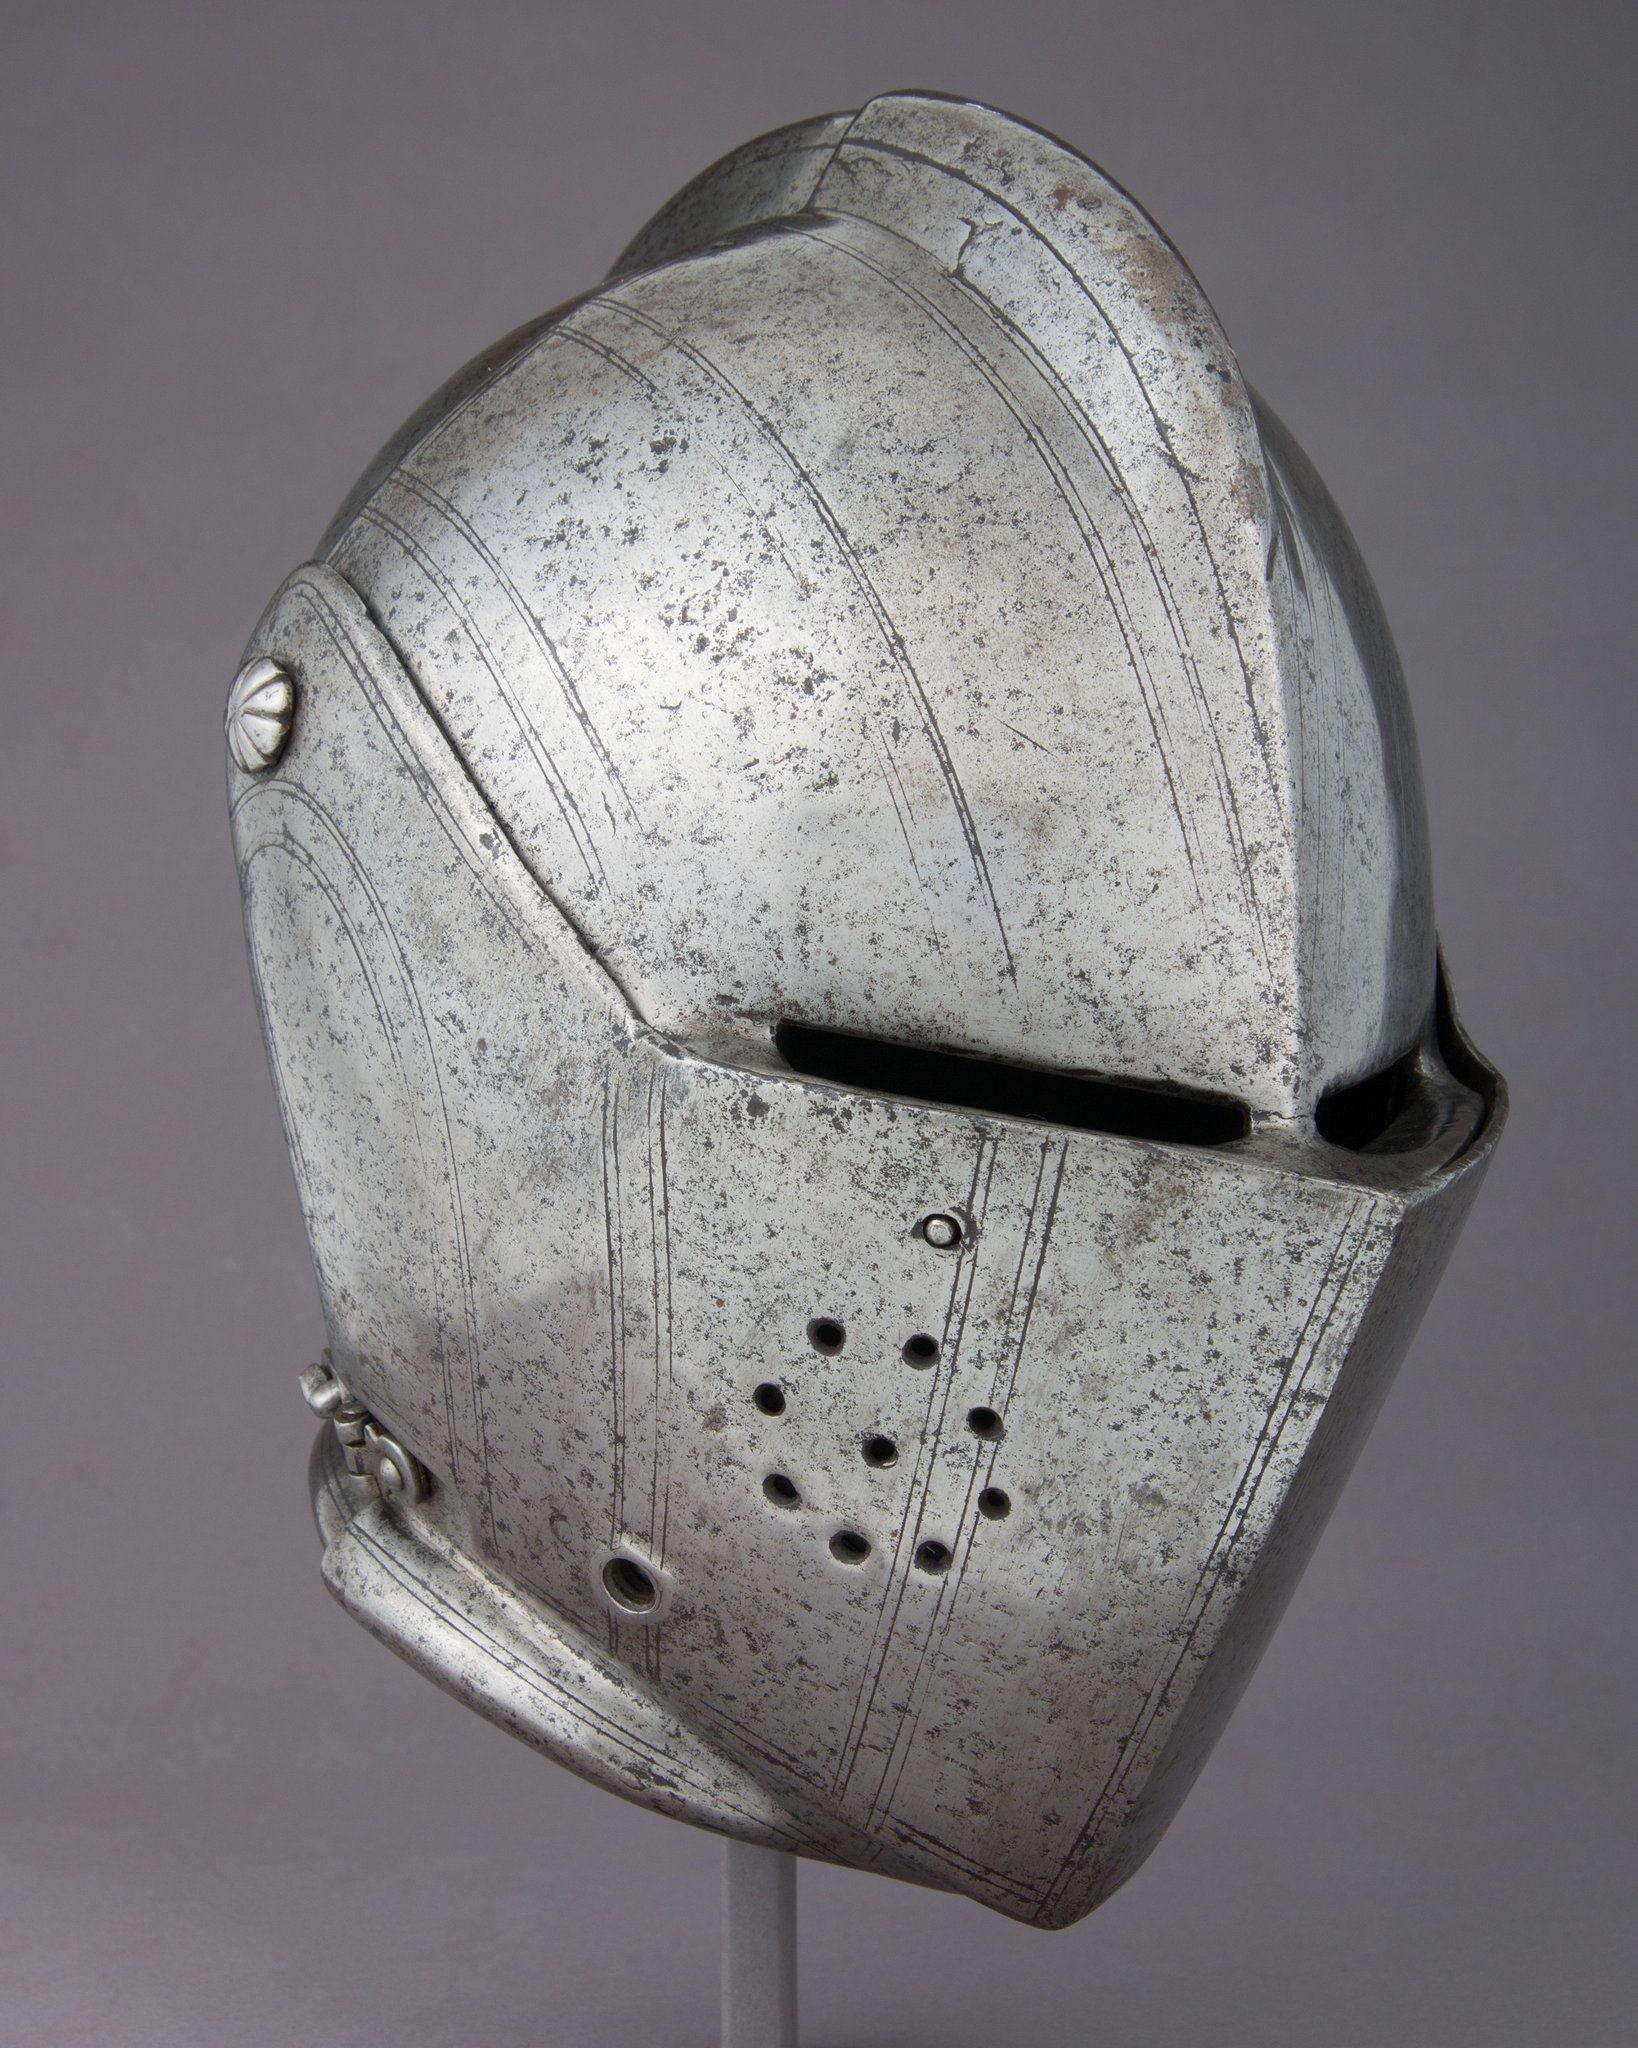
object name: close helmet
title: Close Helmet for Tournament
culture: italian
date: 1600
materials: brass, steel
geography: italy